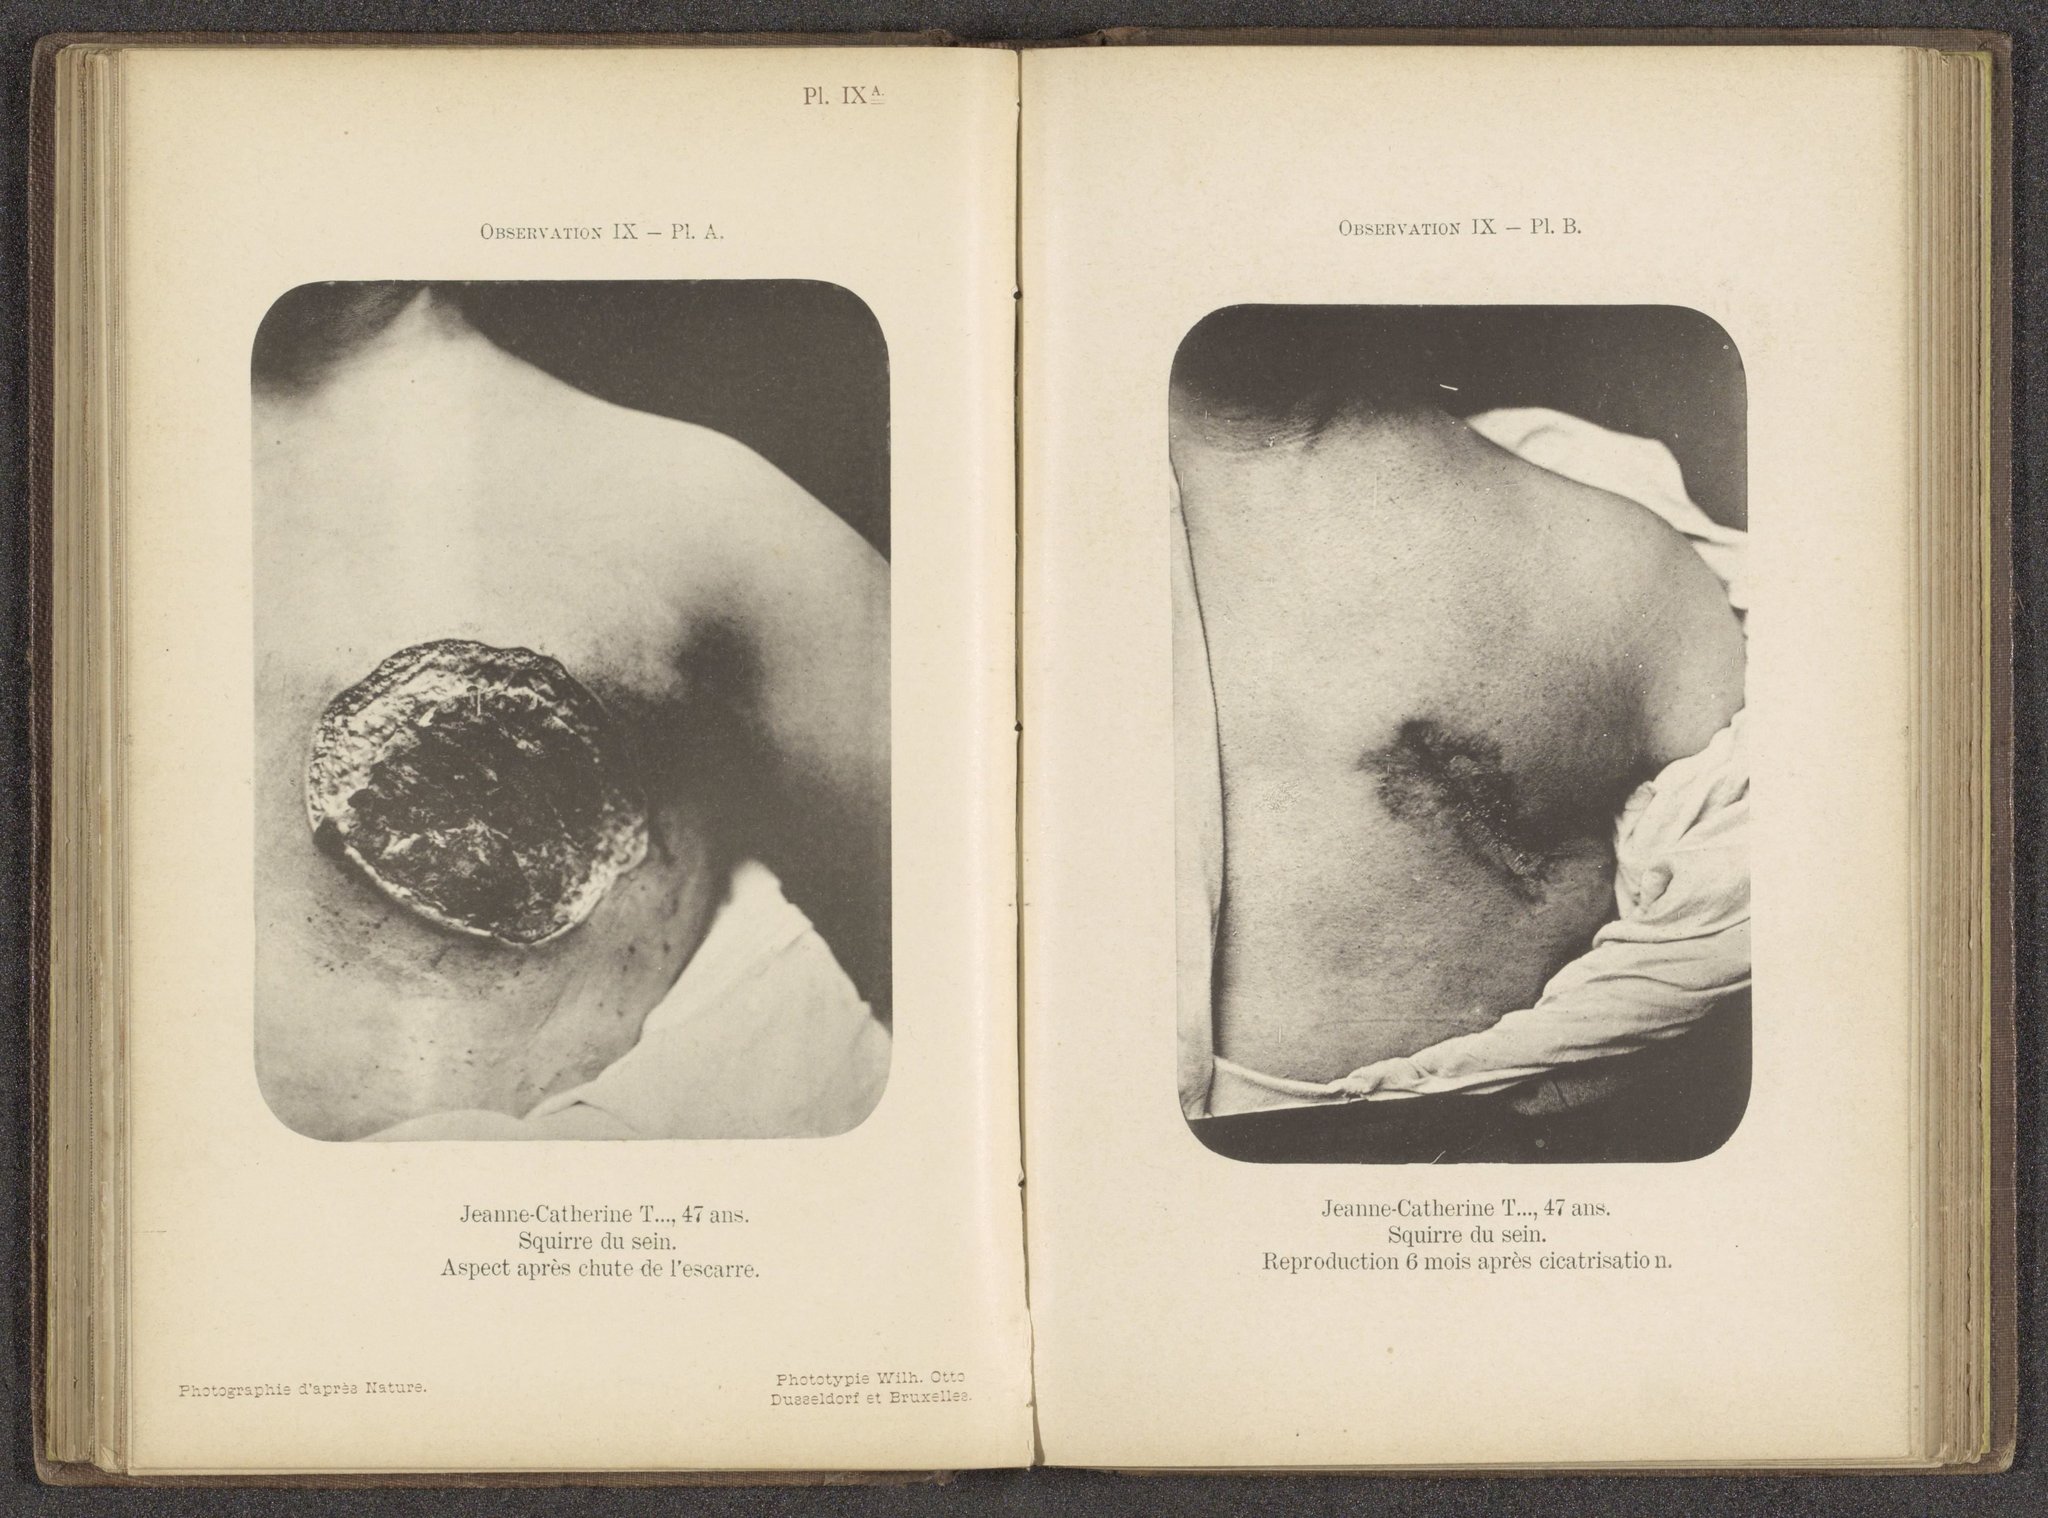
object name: photomechanical print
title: Vrouw van 47 jaar met een borsttumor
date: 1874-1884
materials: paper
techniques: photograph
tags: tumours - aa - female human figure, infections and wounds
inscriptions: inscription: ‘Pl. IXA. / Observation IX - Pl. A. / Jeanne-Catherine T..., 47 ans. Squirre du sein. (...)’